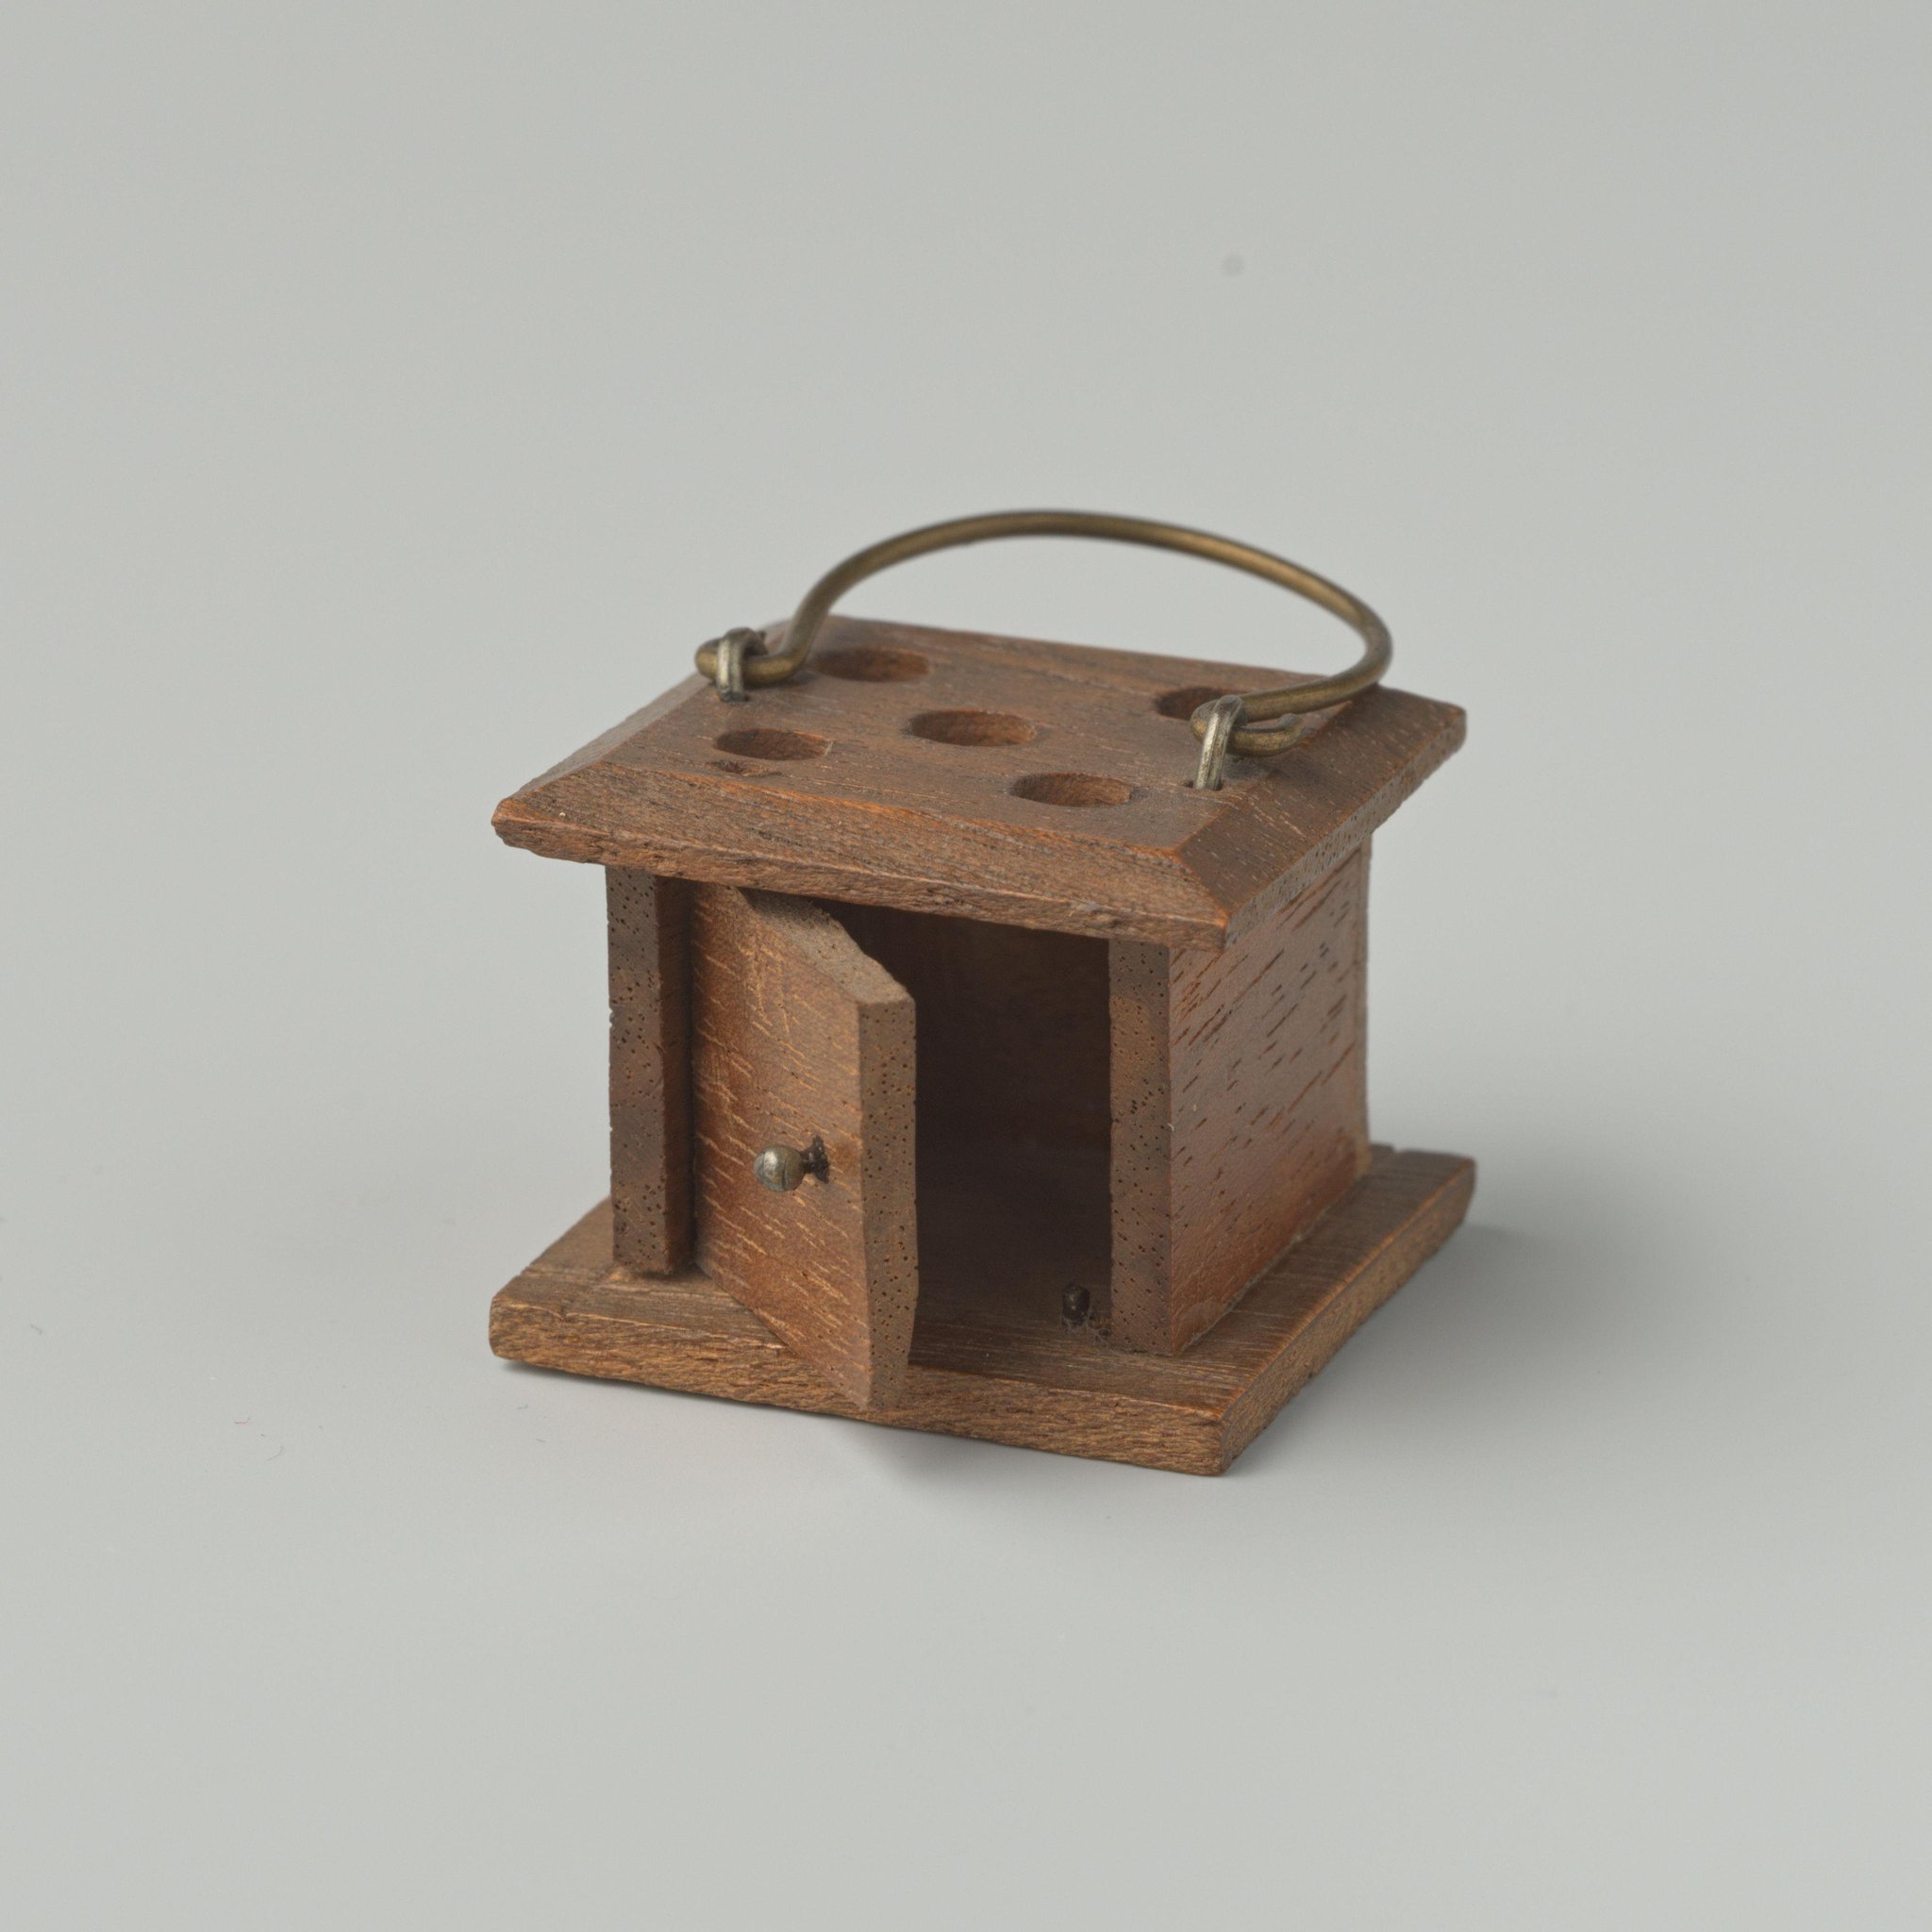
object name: miniature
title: Stoof van notenhout, met deur en messing hengsel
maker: Anonymous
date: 1676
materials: brass, wood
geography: amsterdam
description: Stoof van notenhout, vierkant, met een deur met knop en een messing hengsel.